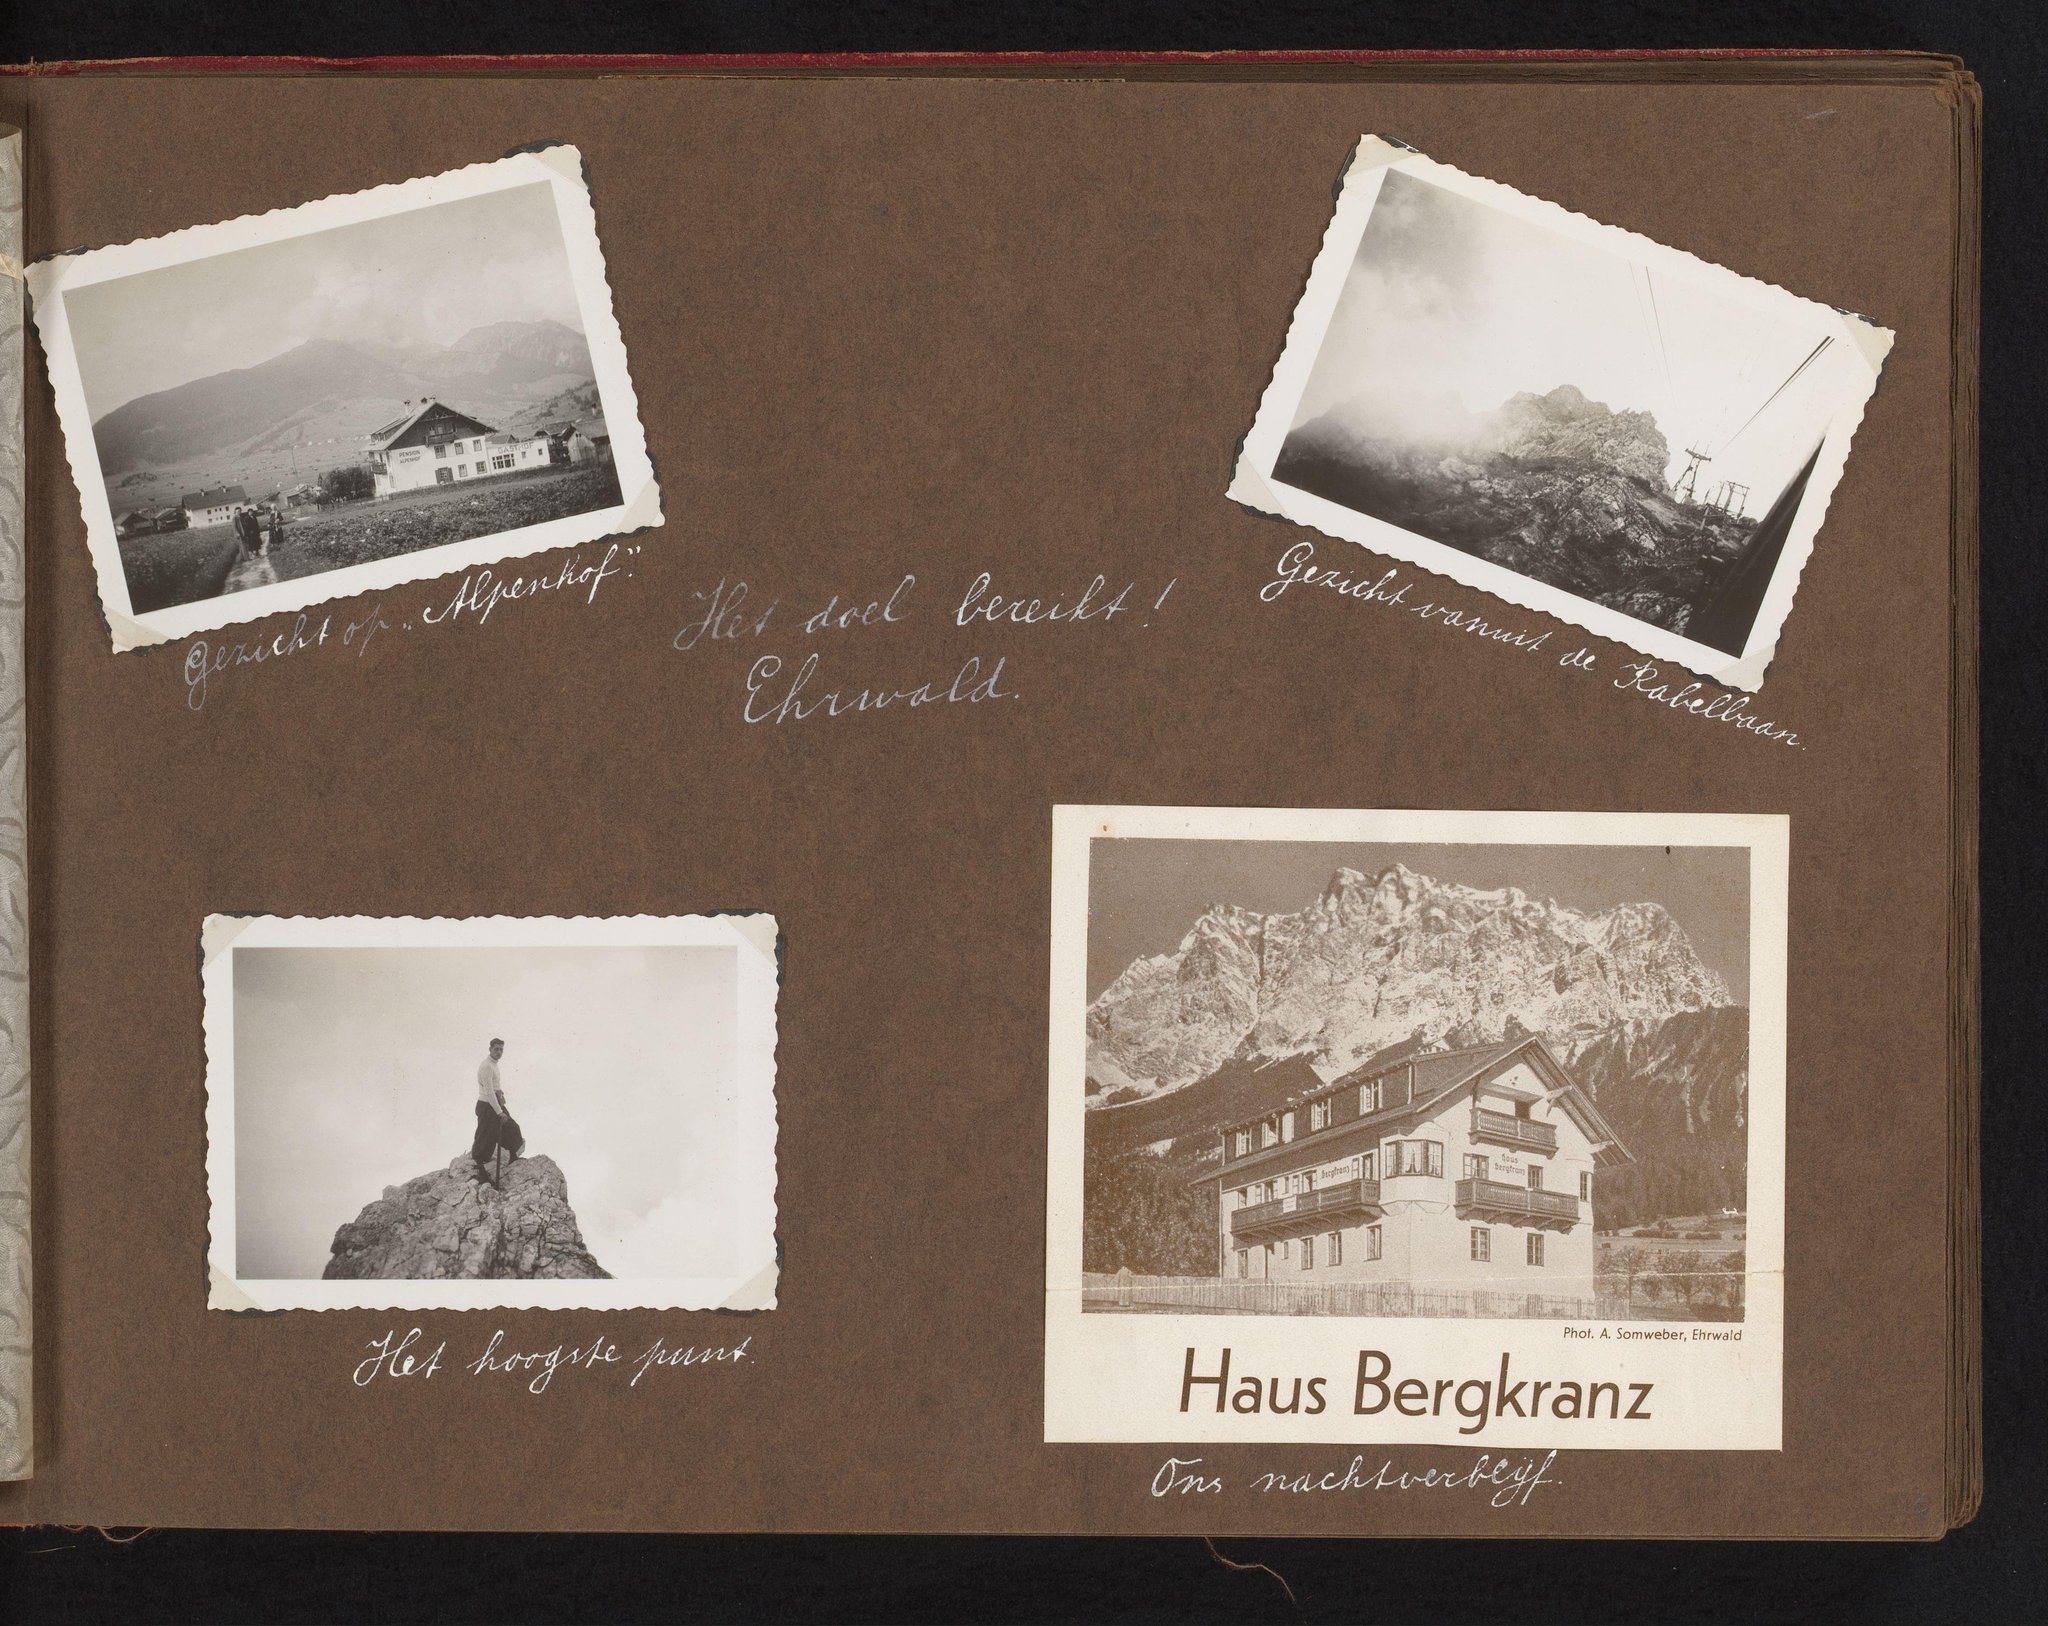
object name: album leaf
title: Het doel bereikt! Ehrwald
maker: Anonymous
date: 1908-1935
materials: paper, photographic support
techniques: gelatin silver print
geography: tirol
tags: outing, pleasure trip, mountain-range, snow peaks, hotel, hostelry, inn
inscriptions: inscription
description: Albumblad met drie foto's van berglandschappen en een afbeelding van het hotel, augustus 1935. Onderdeel van het reisalbum van de familie Van den Broek 1935-1937.